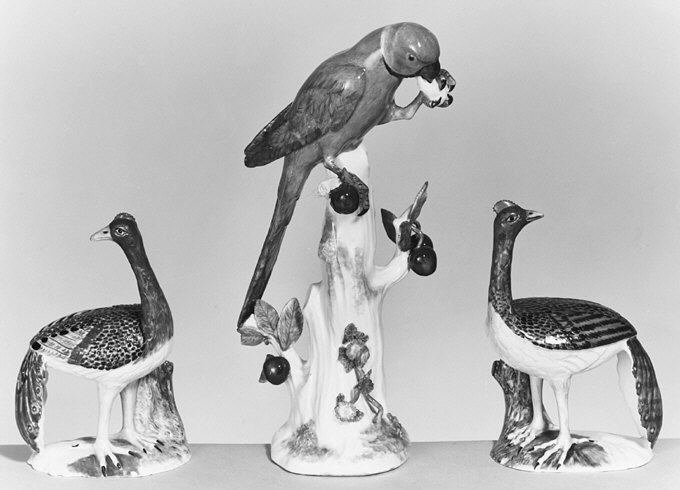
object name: figure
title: Parrot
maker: meissen manufactory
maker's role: manufactory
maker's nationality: german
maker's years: 1710-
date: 1741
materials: hard paste porcelain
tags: parrots